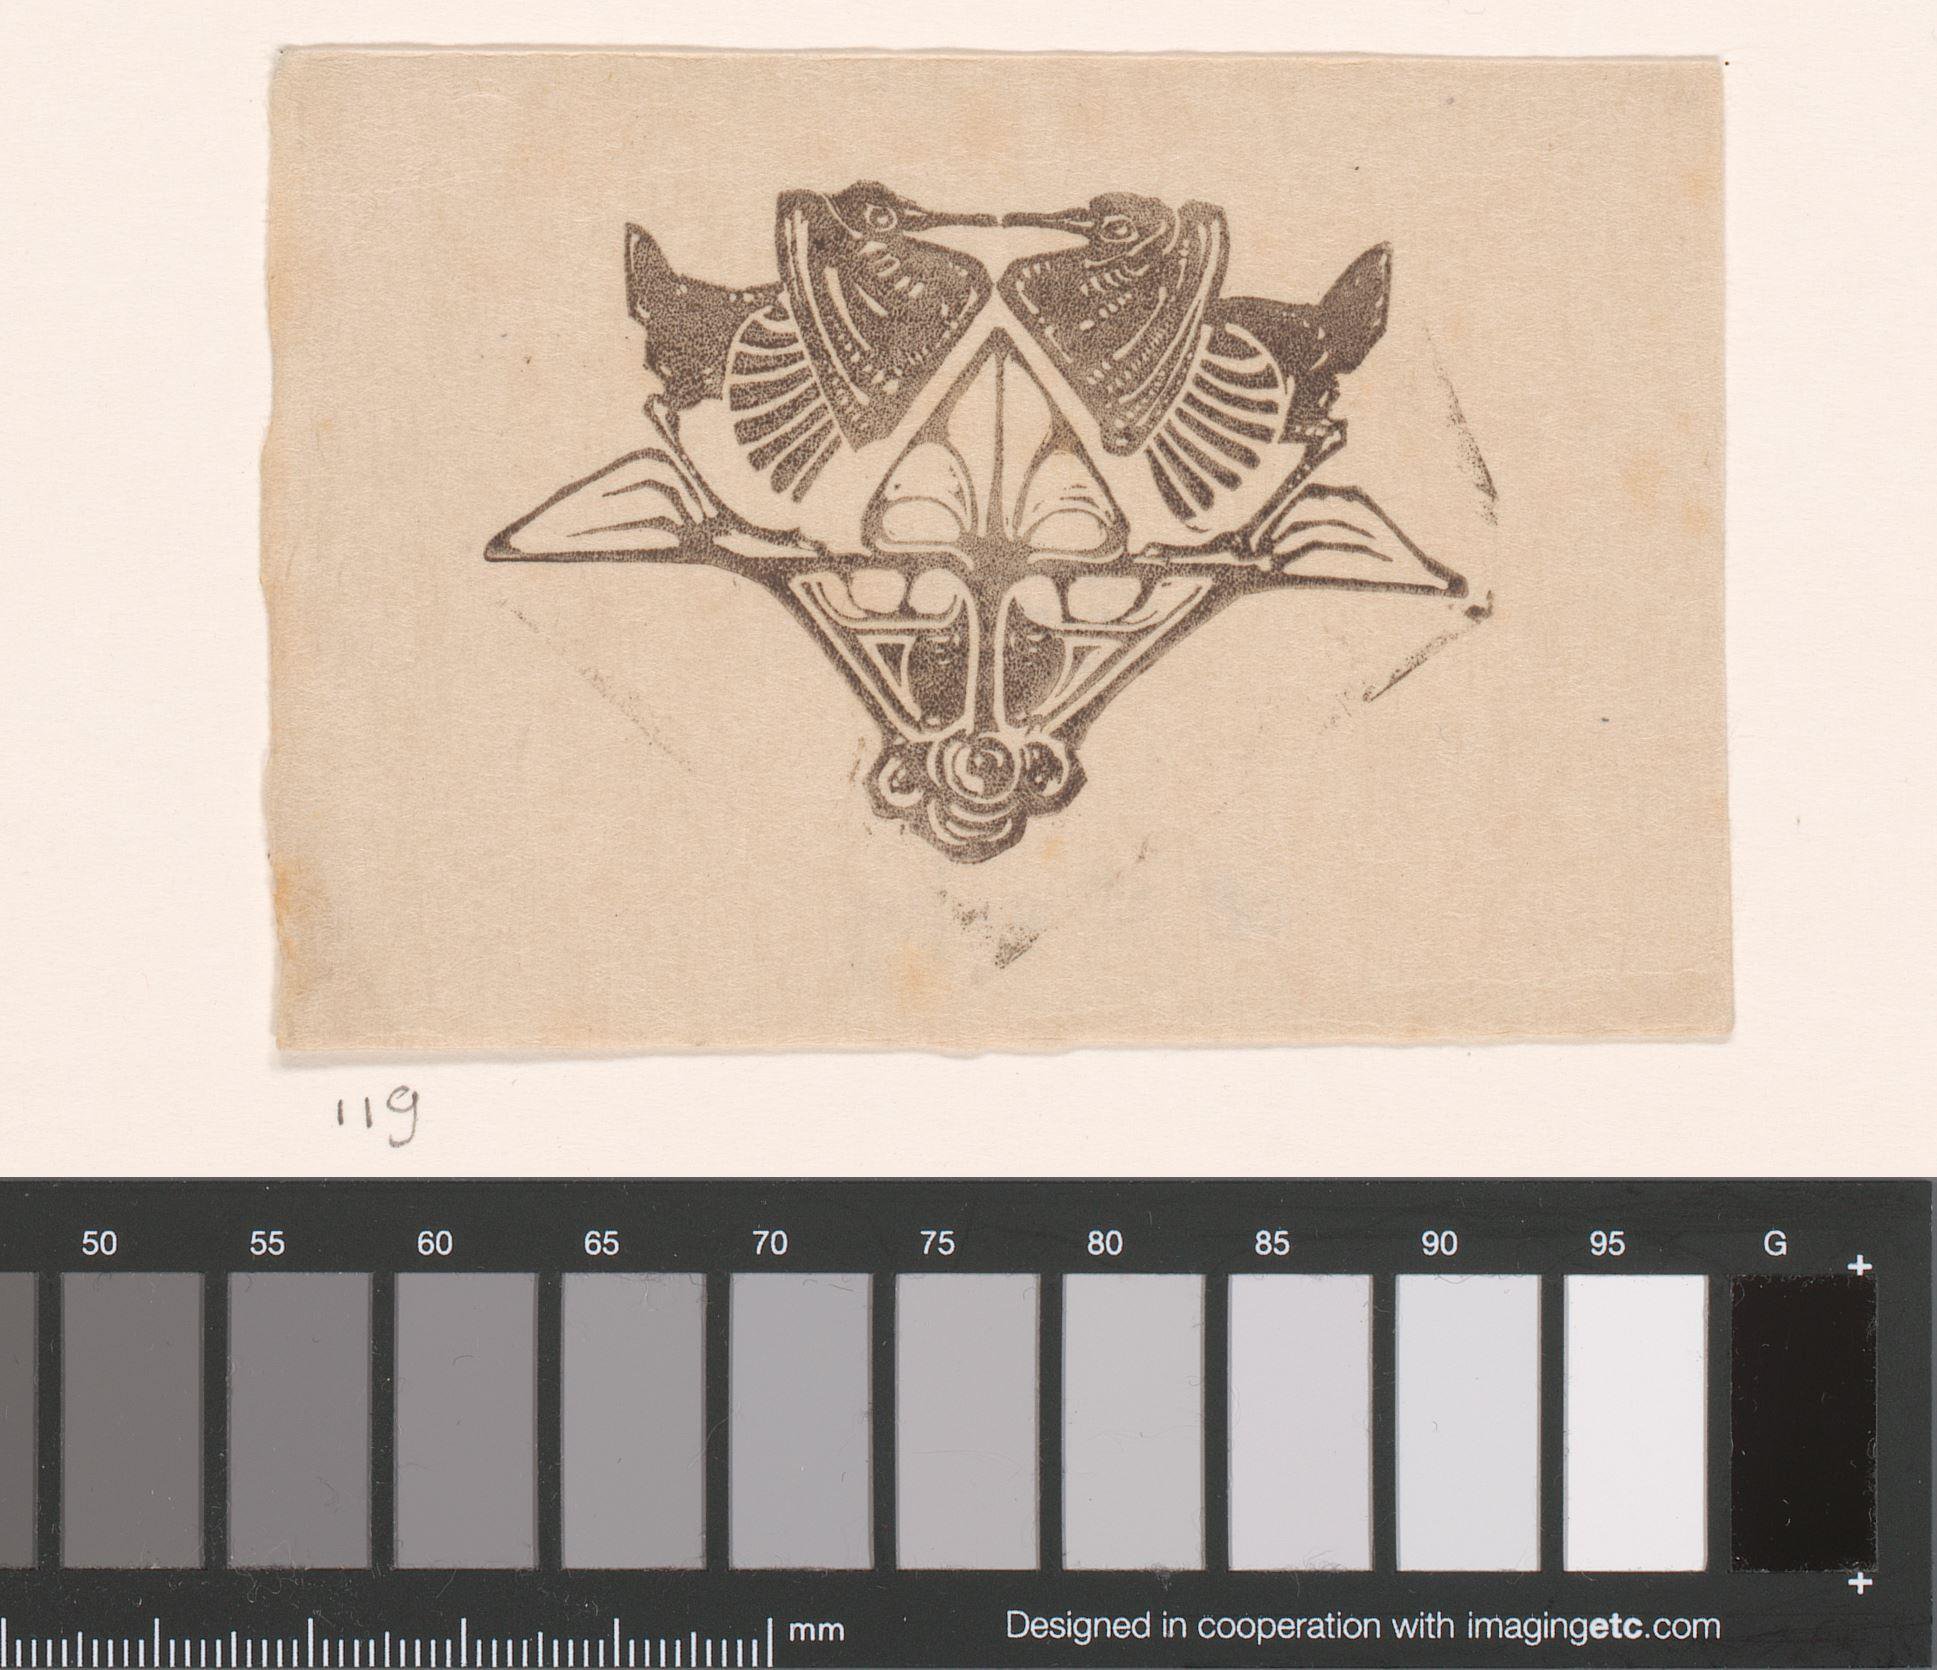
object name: boekillustratie ontwerp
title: Vogels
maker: bernard willem wierink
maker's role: draughtsman, print maker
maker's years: 1856-1939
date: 1910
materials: paper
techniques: relief print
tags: birds, fable of reynard the fox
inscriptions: collector's mark: Lugt 2228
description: Ontwerp voor: Streuvels, Stijn (Frank Lateur). Reinaert de Vos naar verschillende uitgaven van het middeleeuwsche epos. Amsterdam: L.J. Veen, 1910. Deze prent is vermoedelijk een plaatsnede, ook al wordt in de literatuur veelal gesproken over een houtsnede. Voor zover Wierink zijn prenten in hoogdruk zelf nader heeft omschreven, heeft hij altijd de term 'plaatsnede' gebruikt.